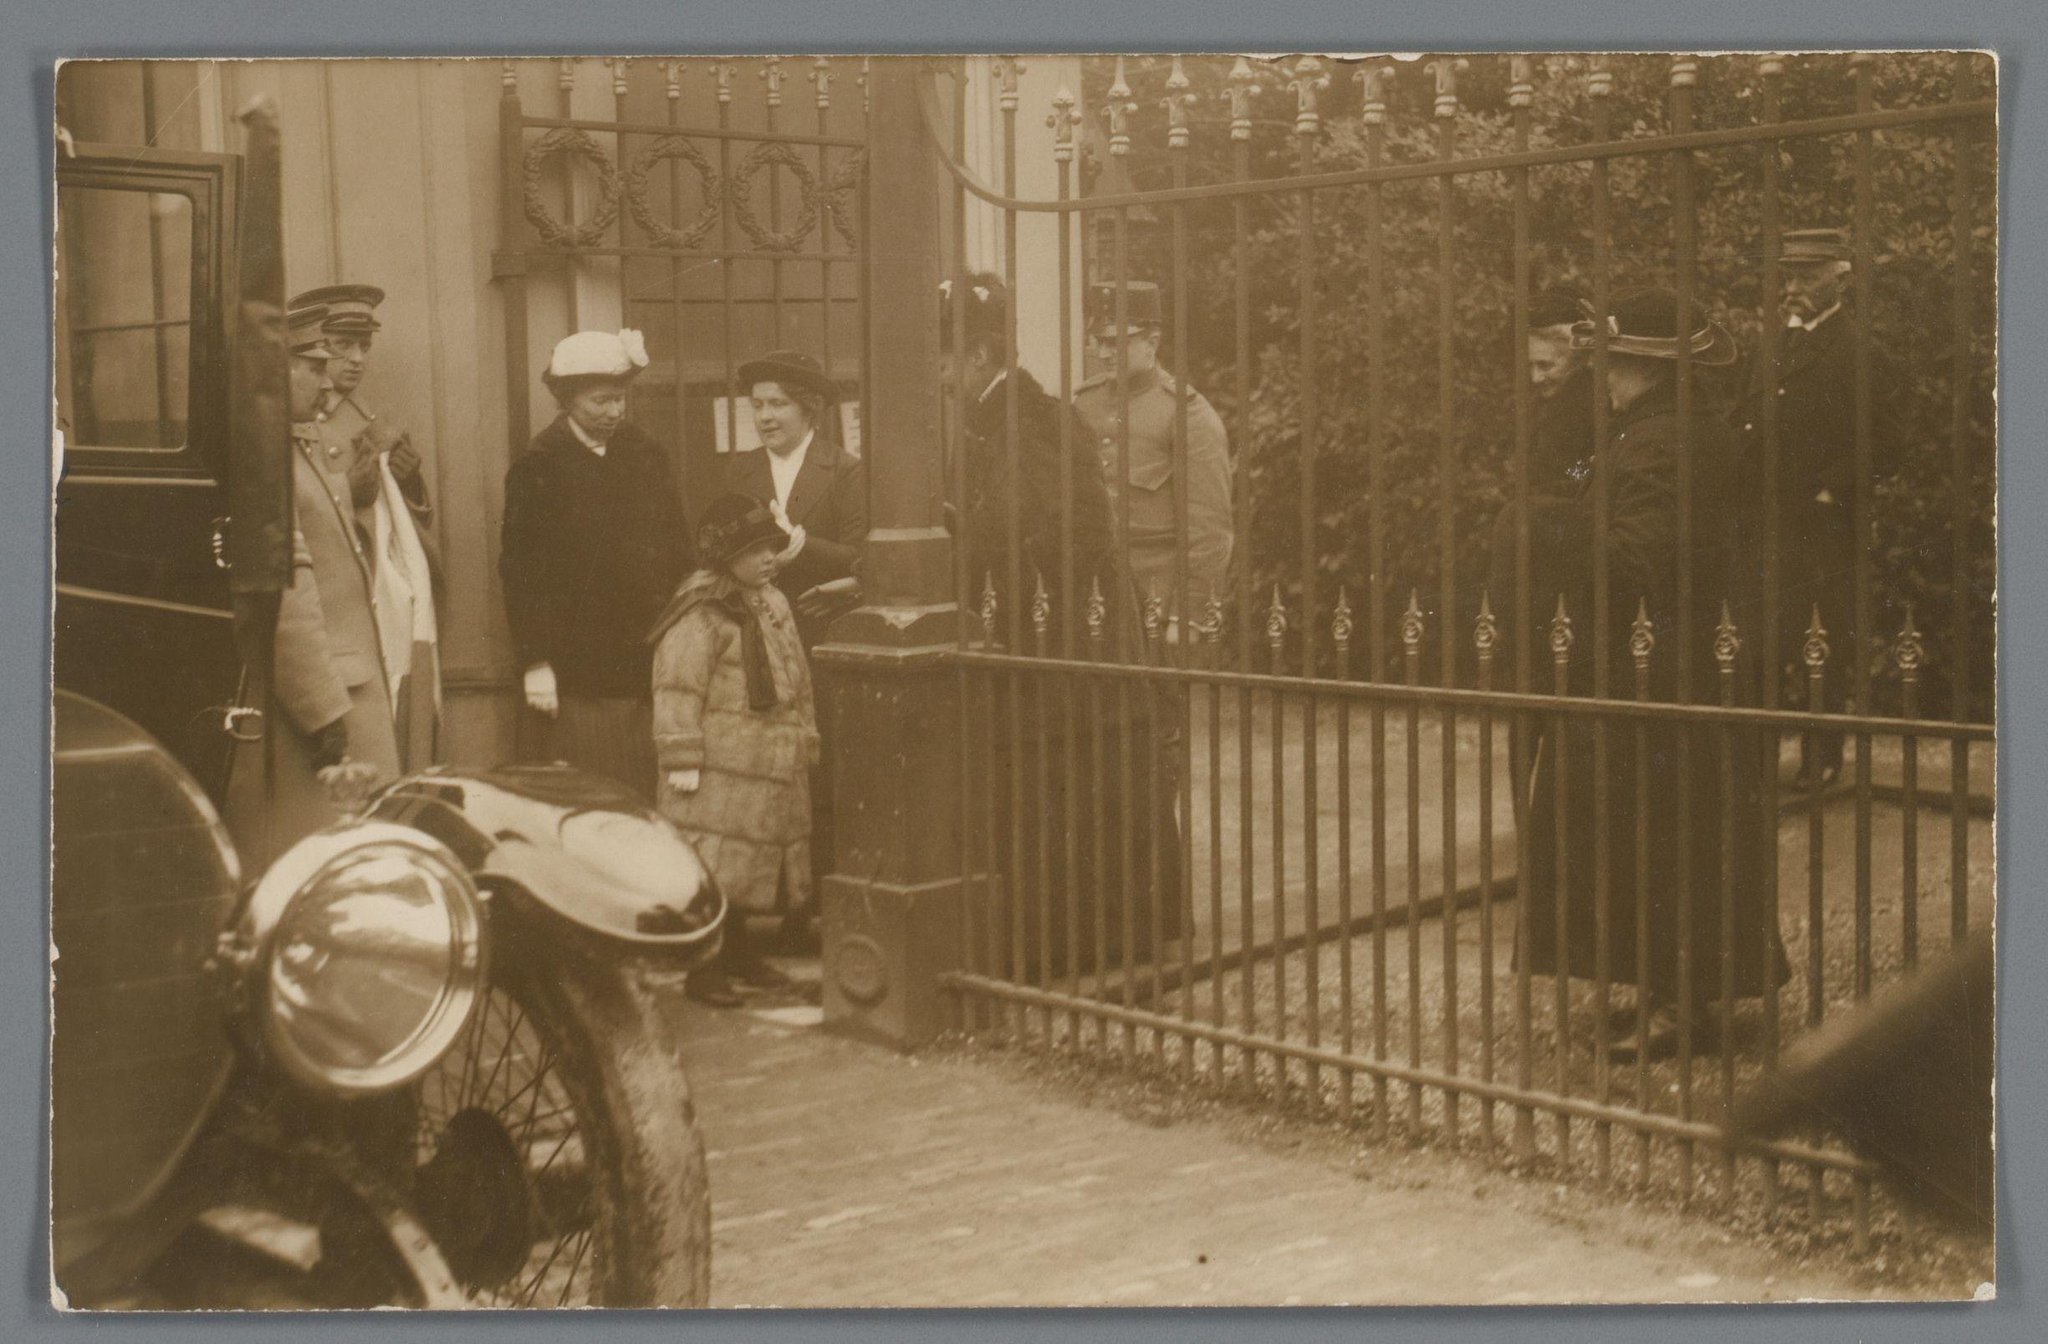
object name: photograph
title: Prinses Juliana bezoekt Artis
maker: Anonymous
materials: paper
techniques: gelatin silver print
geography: amsterdam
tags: the hague, juliana of the netherlands, gate, entrance, princess, automobile, zoo (as place of recreation)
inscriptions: number: ‘5’, number: ‘1243’